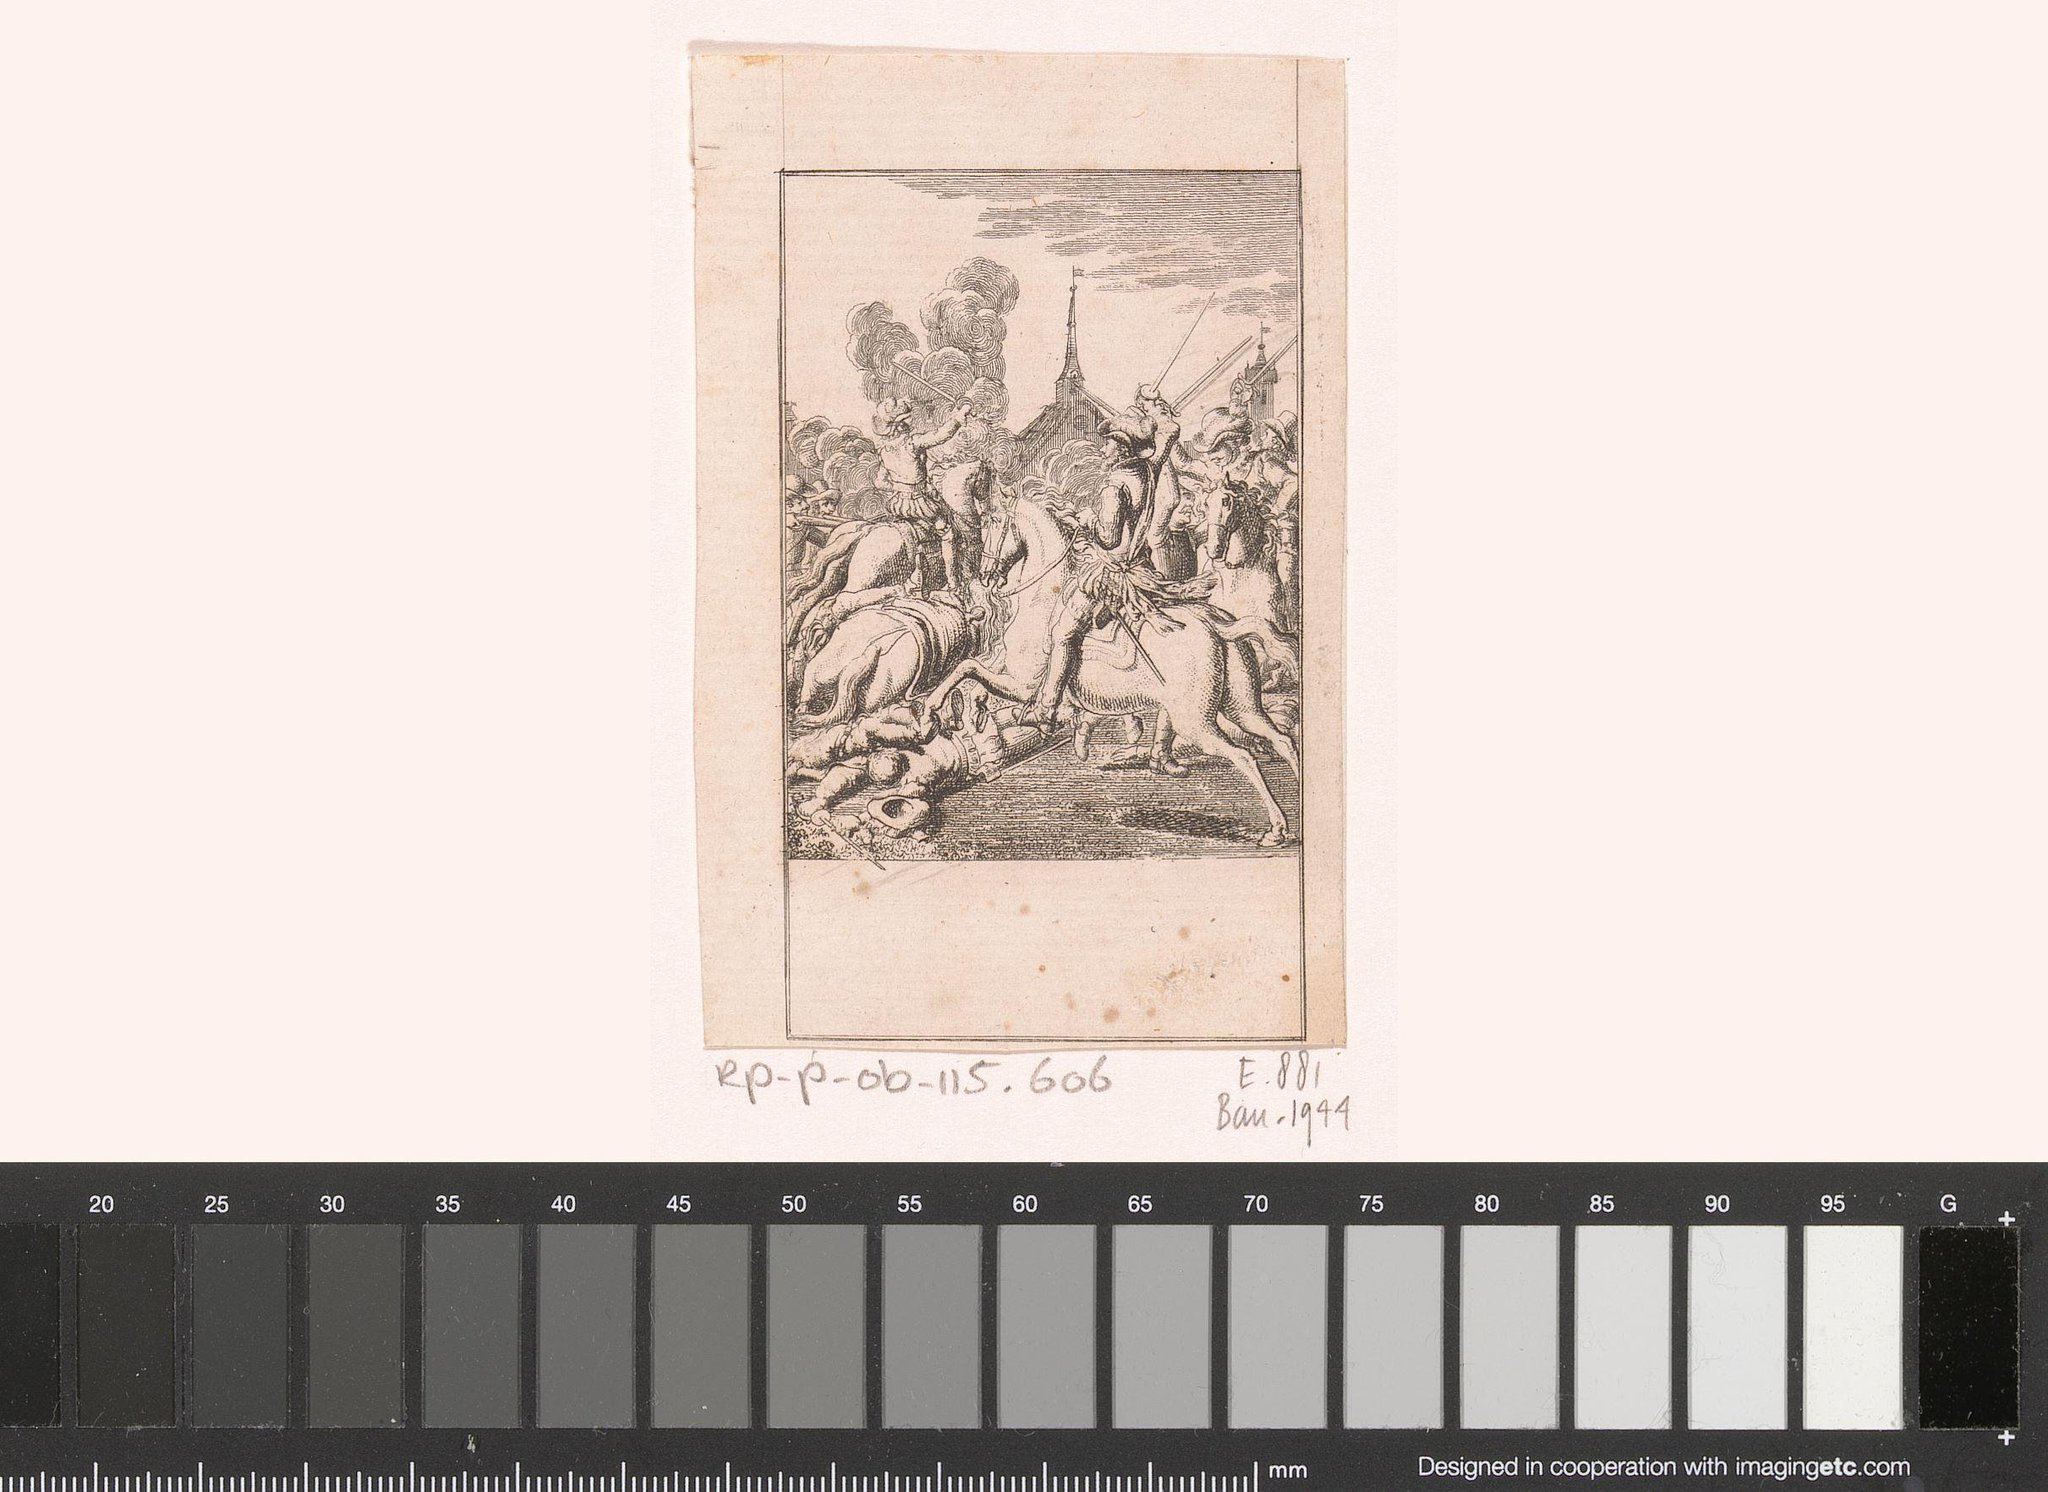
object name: print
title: François de Guise raakt gewond bij het gevecht in Vassy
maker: daniel nikolaus chodowiecki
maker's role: draughtsman, print maker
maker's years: 1726-1801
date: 1798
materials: paper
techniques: etching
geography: berlin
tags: battle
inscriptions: collector's mark: Lugt 2228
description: Prent gebruikt voor: Historisch-genealogischer Kalender auf das Jahr 1799 und 1800. Die Geschichte der Bartholomäusnacht oder die Bluthochzeit zu Paris. Berlijn: Johann Friedrich Unger, [1798].